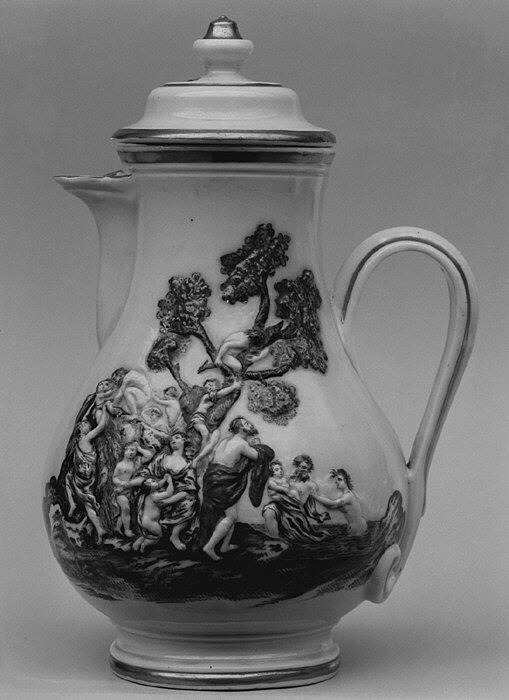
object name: creamer with cover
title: Creamer with cover (part of a service)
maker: doccia porcelain manufactory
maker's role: manufactory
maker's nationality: italian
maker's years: 1737-1896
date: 1760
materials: hard paste porcelain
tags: children,men,women